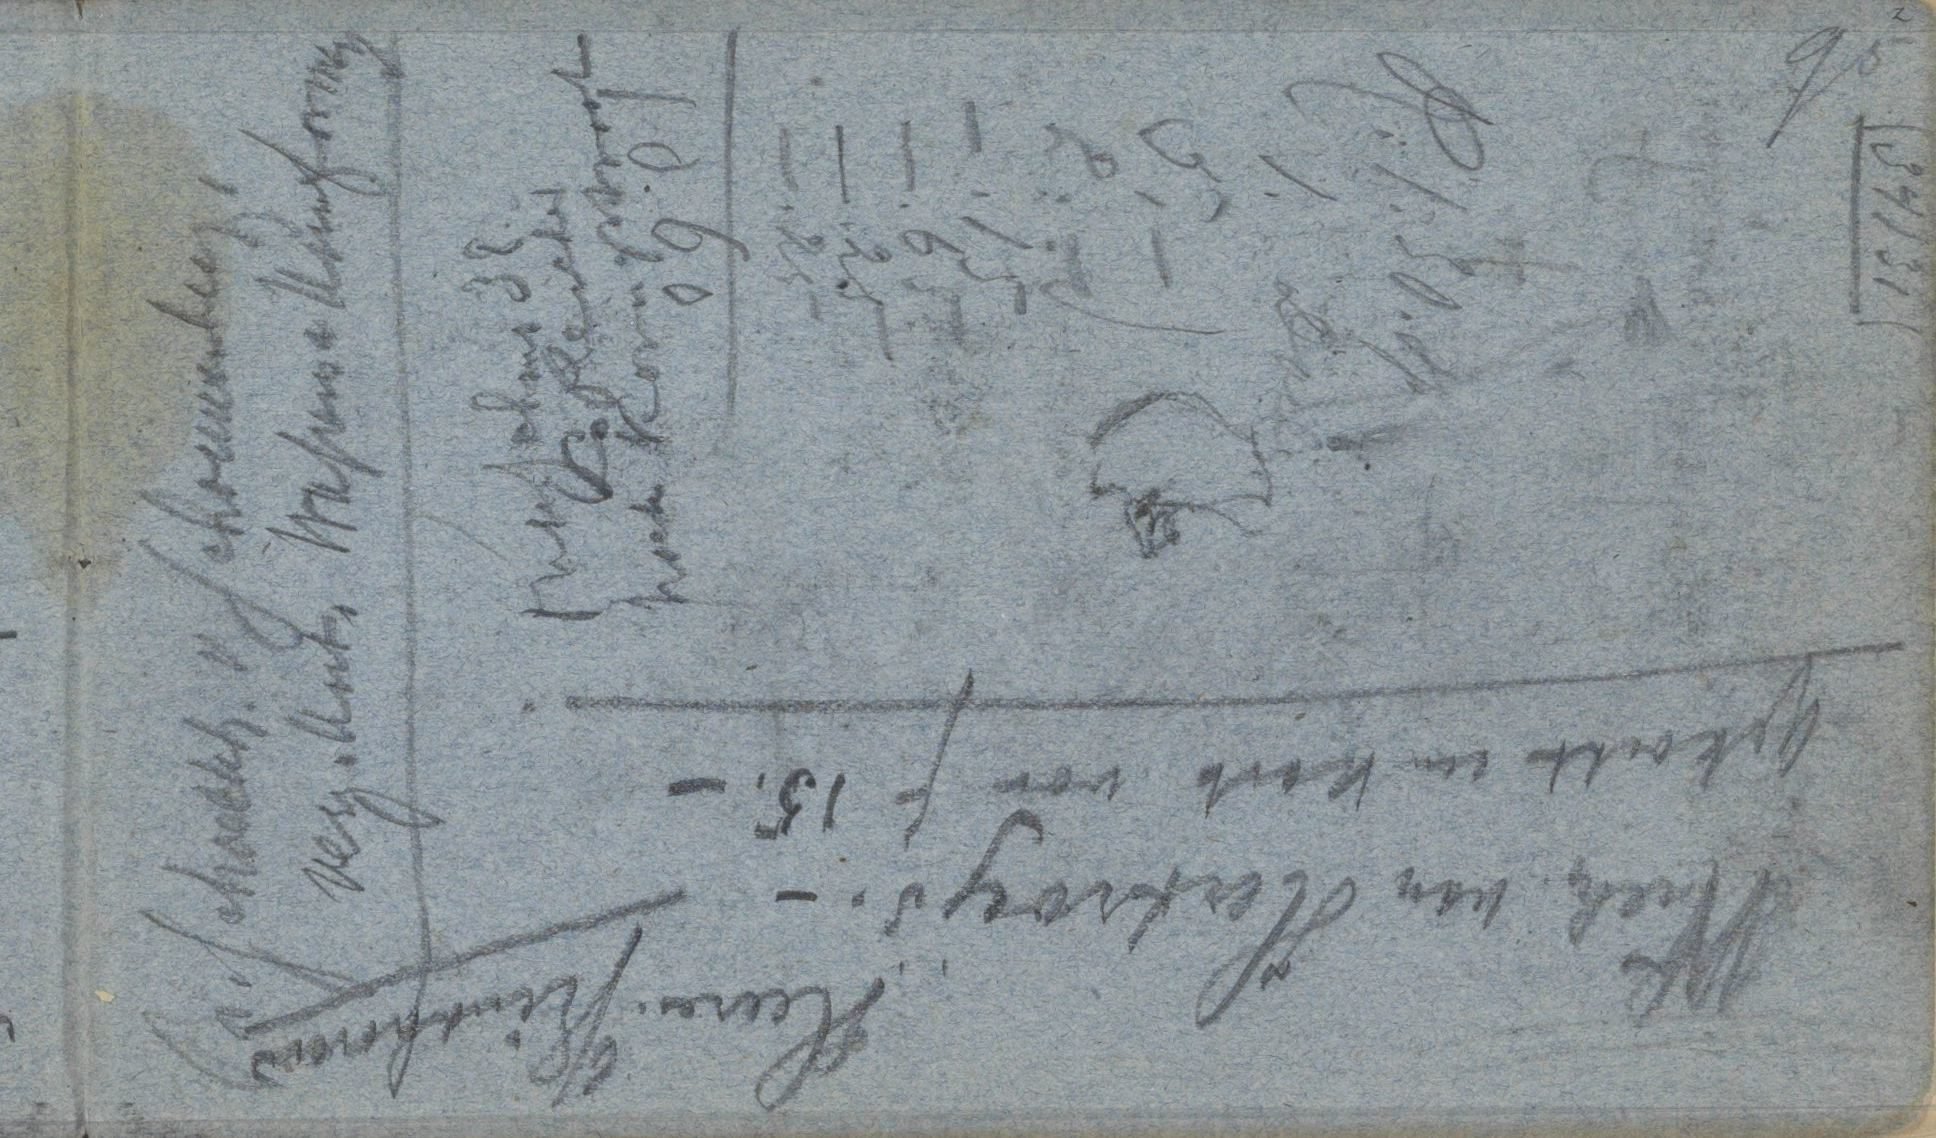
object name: endleaf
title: Studie en annotaties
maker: george hendrik breitner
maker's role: draughtsman, painter, print maker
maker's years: 1857-1923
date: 1881-1883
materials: paper, pencil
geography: north brabant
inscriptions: annotation: ‘Heere[?] b/ Eindhoven/ [...] van Hertroys/ gekocht een kerk[?] voor f 15,-/ [...]’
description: Pagina 2, vrij schutblad, uit een schetsboek met 42 bladen.